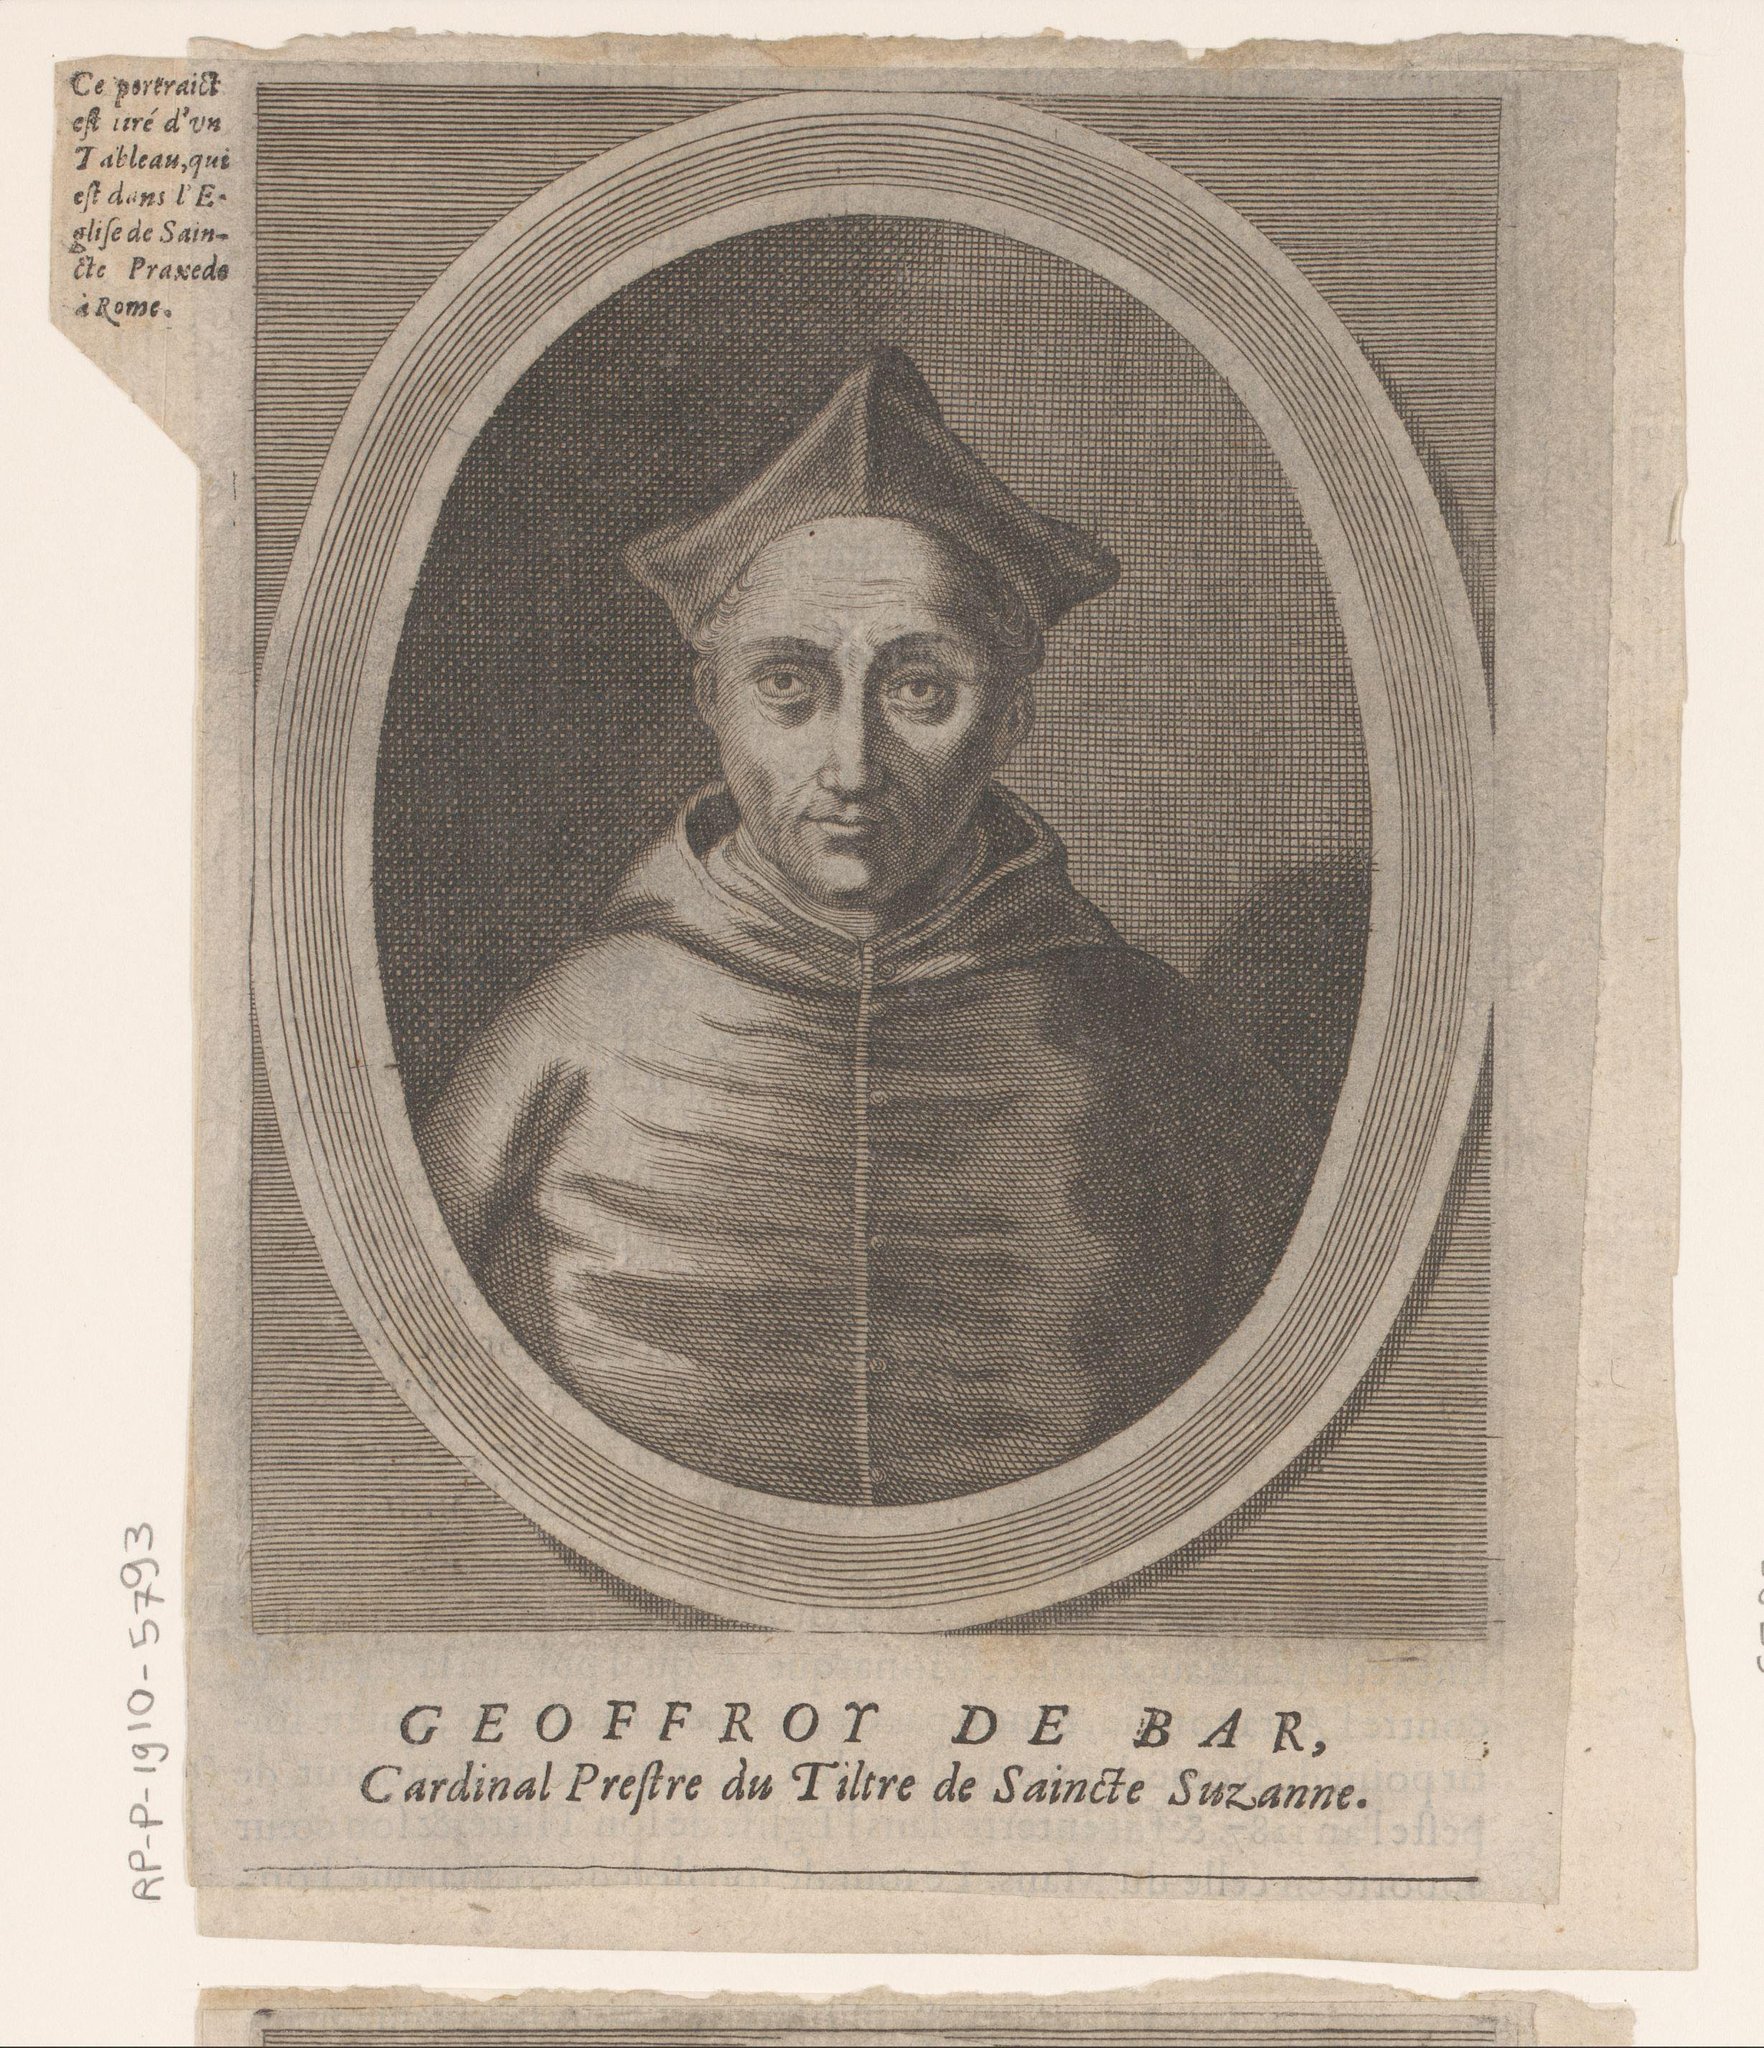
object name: book illustration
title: Geoffroy de Bar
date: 1660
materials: paper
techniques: engraving, etching, letterpress printing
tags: rome, priest, cardinal, historical persons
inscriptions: collector's mark: Lugt 2228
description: Prent uit: Du Chesne, François. Histoire de tous les cardinaux françois de naissance, ou qui ont esté promeus au cardinalat. Parijs: François Du Chesne, 1660.